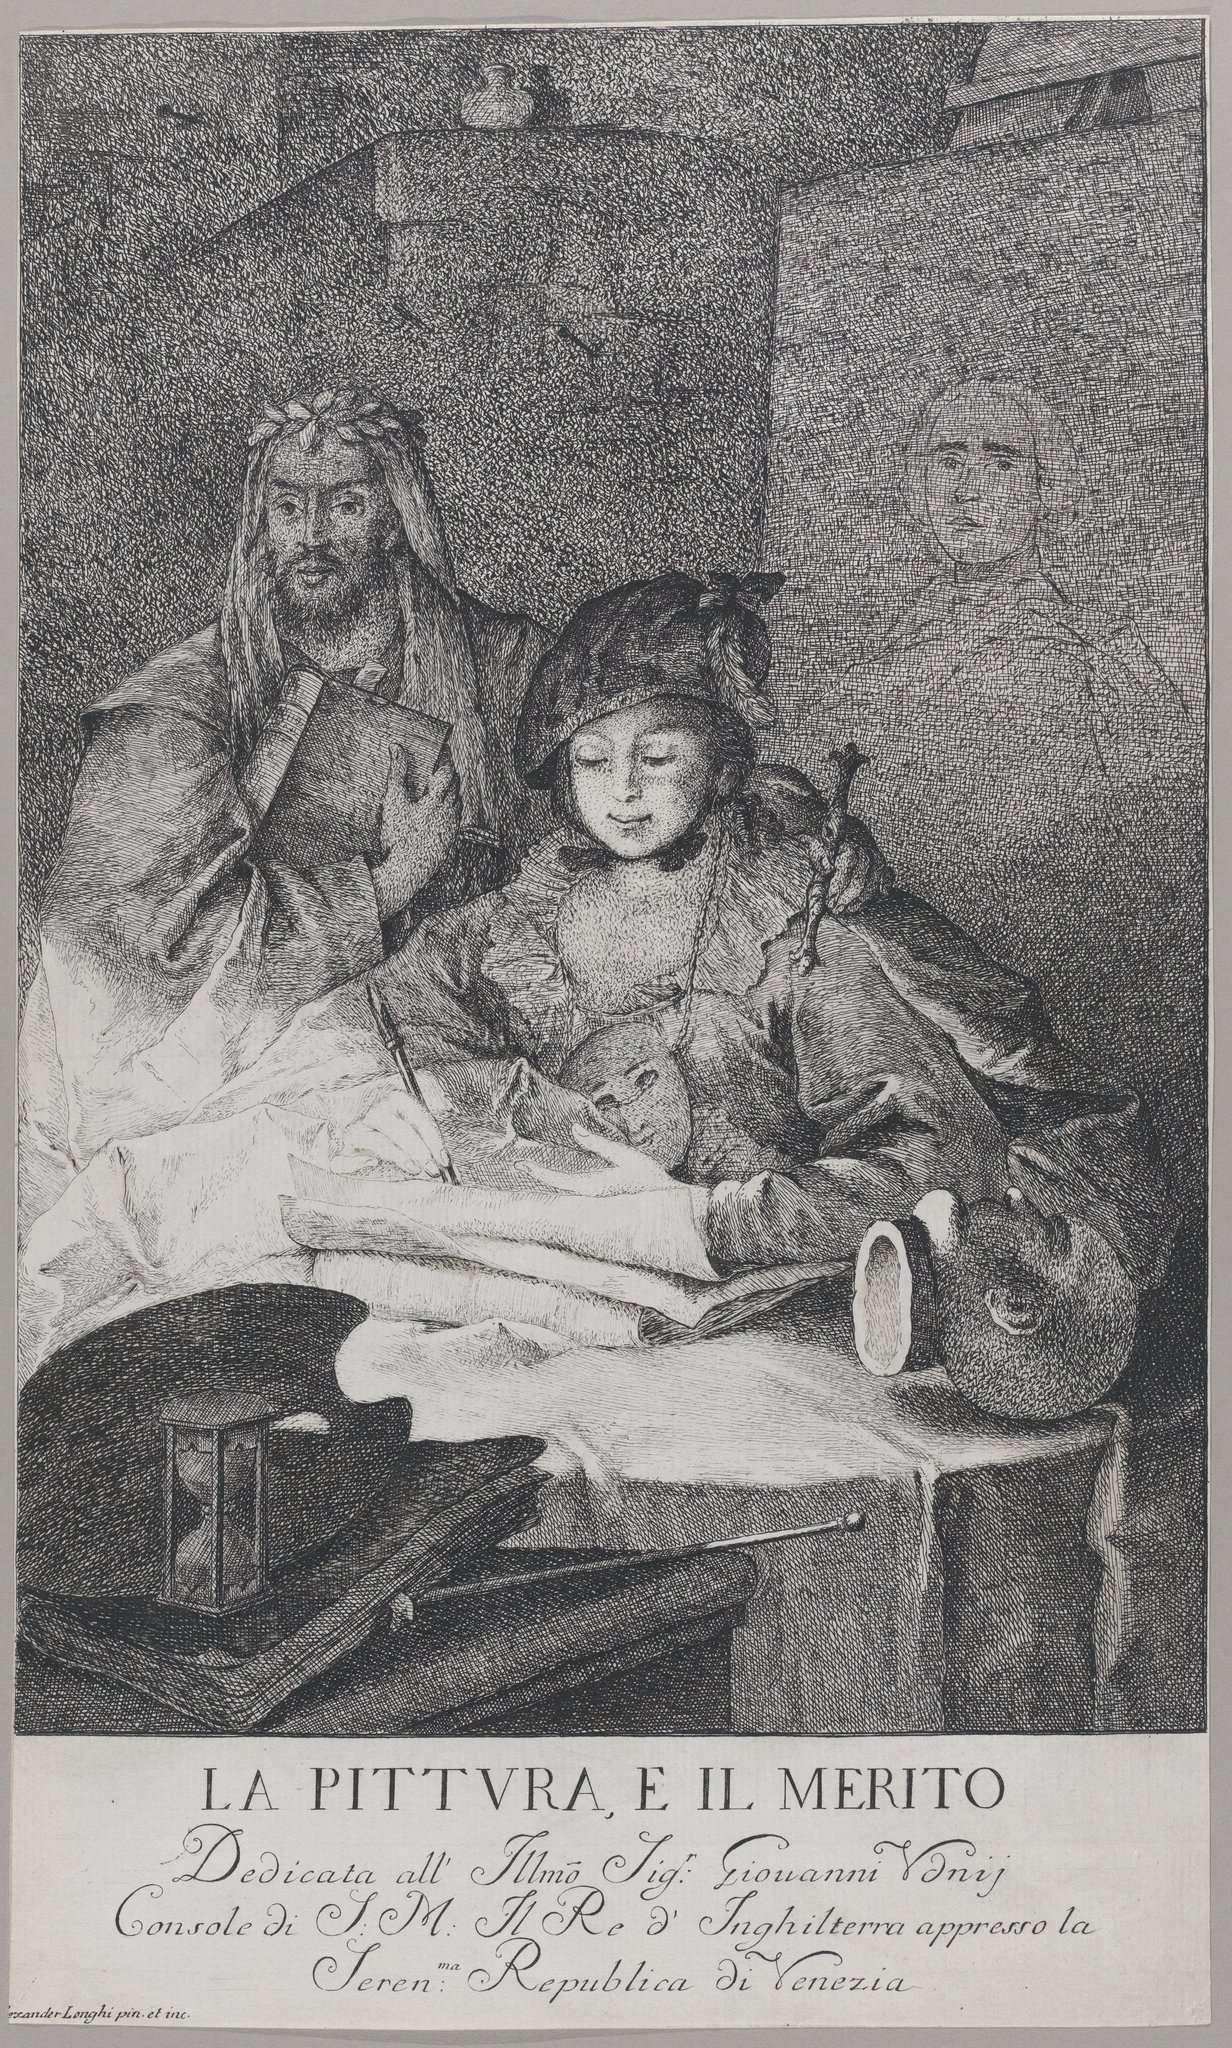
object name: print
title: Painting and Merit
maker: alessandro longhi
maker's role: artist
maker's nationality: italian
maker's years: 1733-1813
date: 1761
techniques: etching